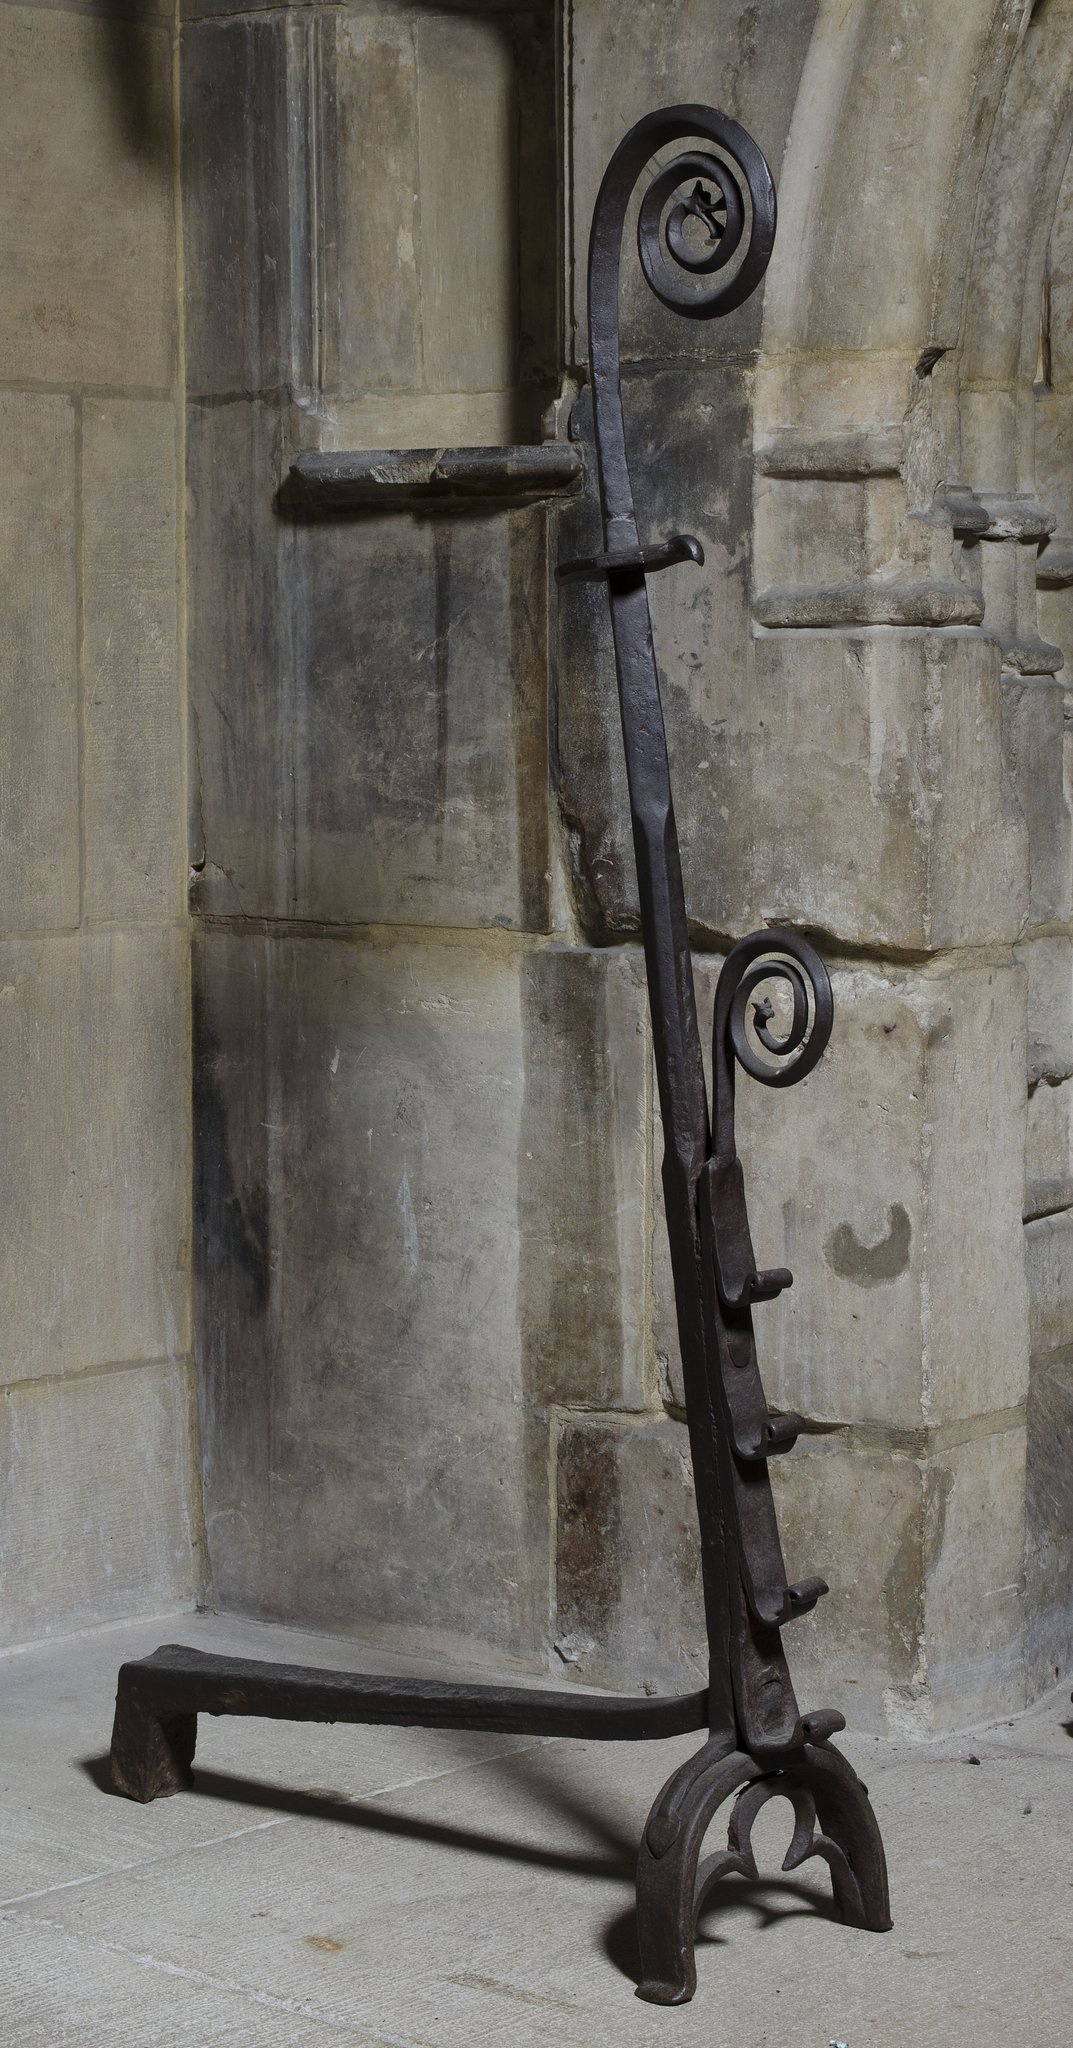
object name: andiron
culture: french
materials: iron